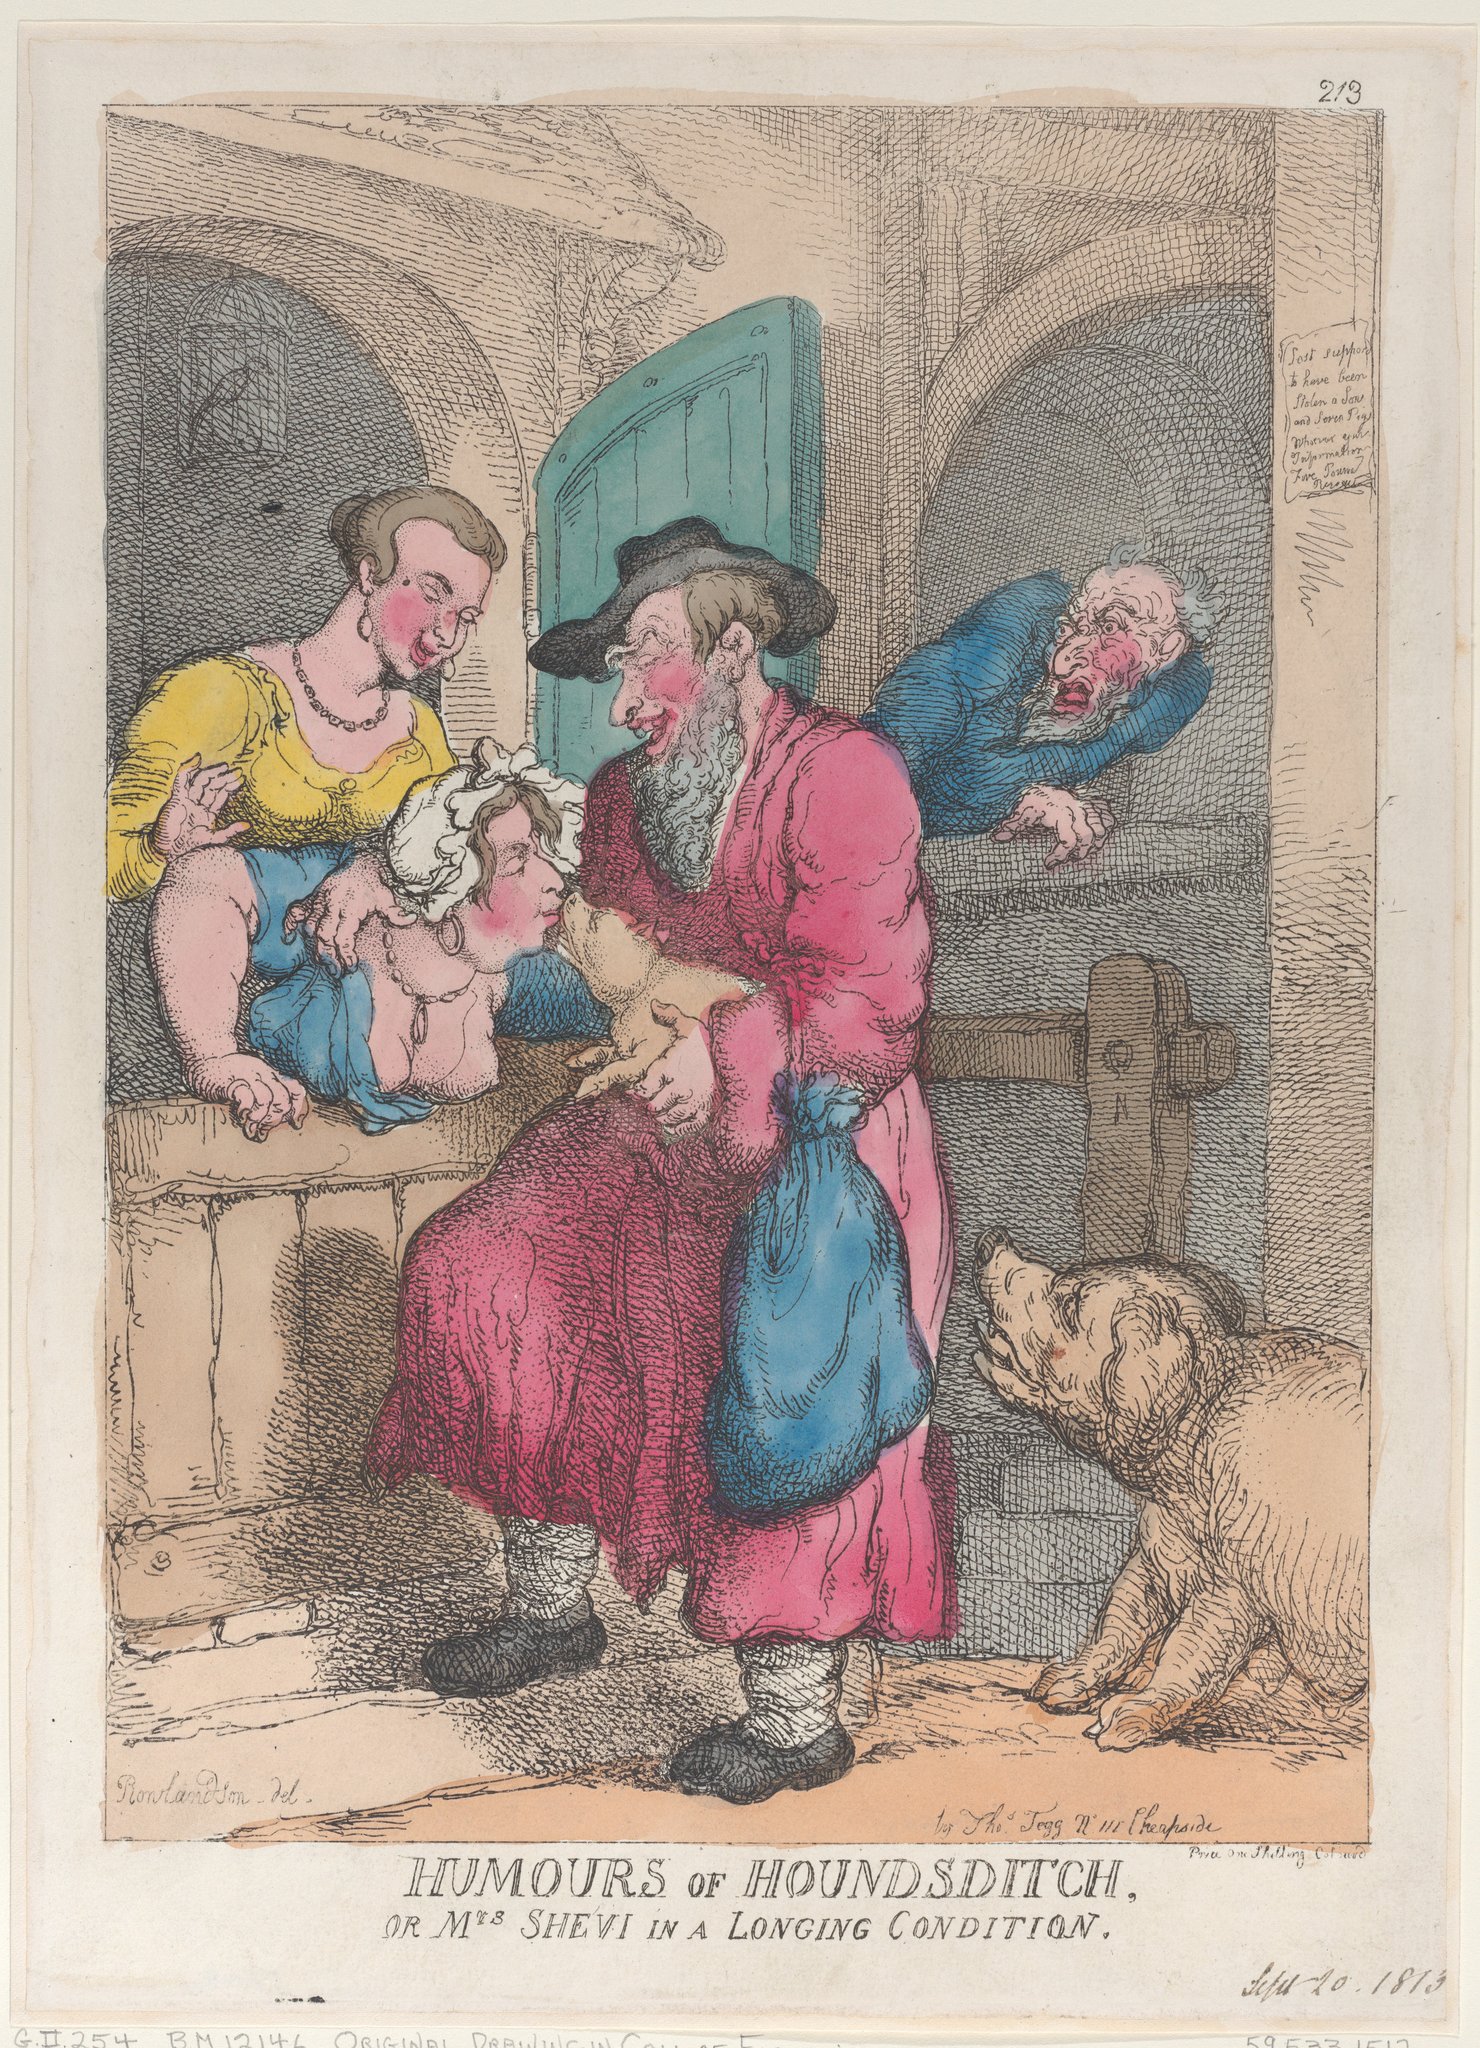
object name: print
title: Humors of Houndsditch, or Mrs. Shevi in a Longing Condition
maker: thomas rowlandson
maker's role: artist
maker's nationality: british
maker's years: 1757-1827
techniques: etching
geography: london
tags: satire,men,women,pigs